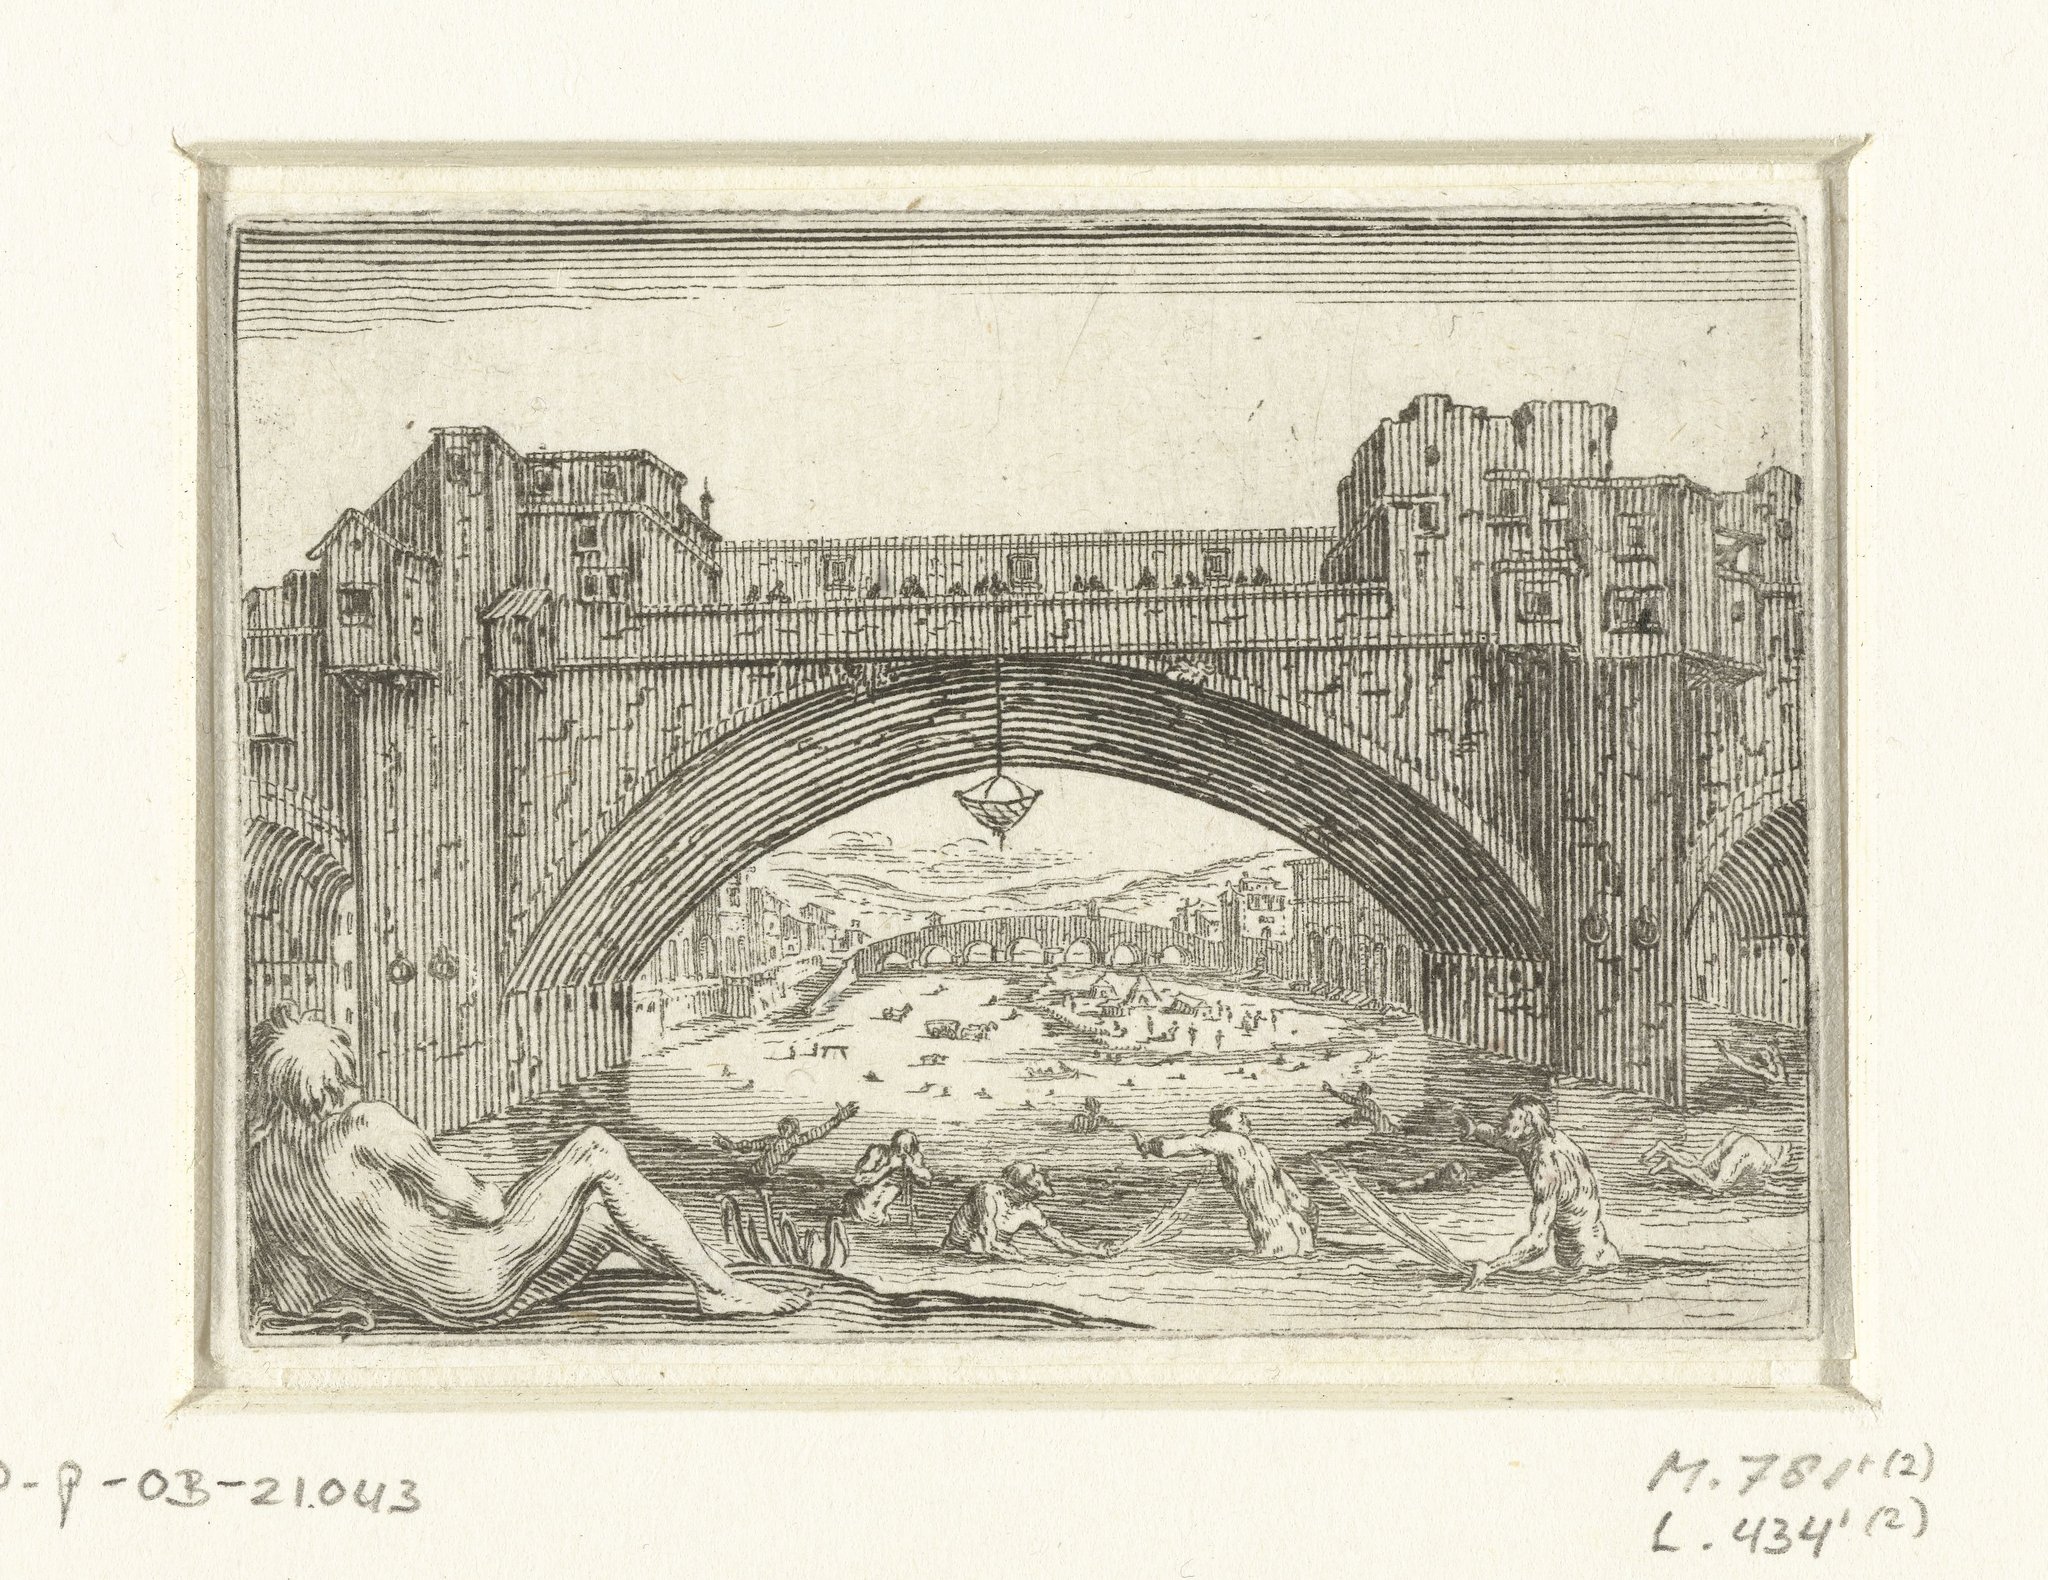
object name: print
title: Capricci di varie Figure di Jacopo Callot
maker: jacques callot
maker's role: draughtsman, print maker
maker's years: 1592-1635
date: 1621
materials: paper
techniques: etching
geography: nancy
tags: swimming (movement in water), bridge in city with structures, i.e. shops, houses, e.g. ponte vecchio in florence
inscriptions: collector's mark: Lugt 240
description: Callot maakte een eerste versie van de prentserie 'Capricci di varie Figure' in Florence rond 1617. Omdat deze in relatief zachte koperplaten was geëtst en snel sleet, maakte hij een tweede in Nancy in 1621. De twee versies zijn slechts op details van elkaar te onderscheiden. De reeks die het Rijksmuseum bezit, bestaat op 1 prent (RP-P-OB-21.081) na uit Franse exemplaren d.d. 1621. Klinkert, C.